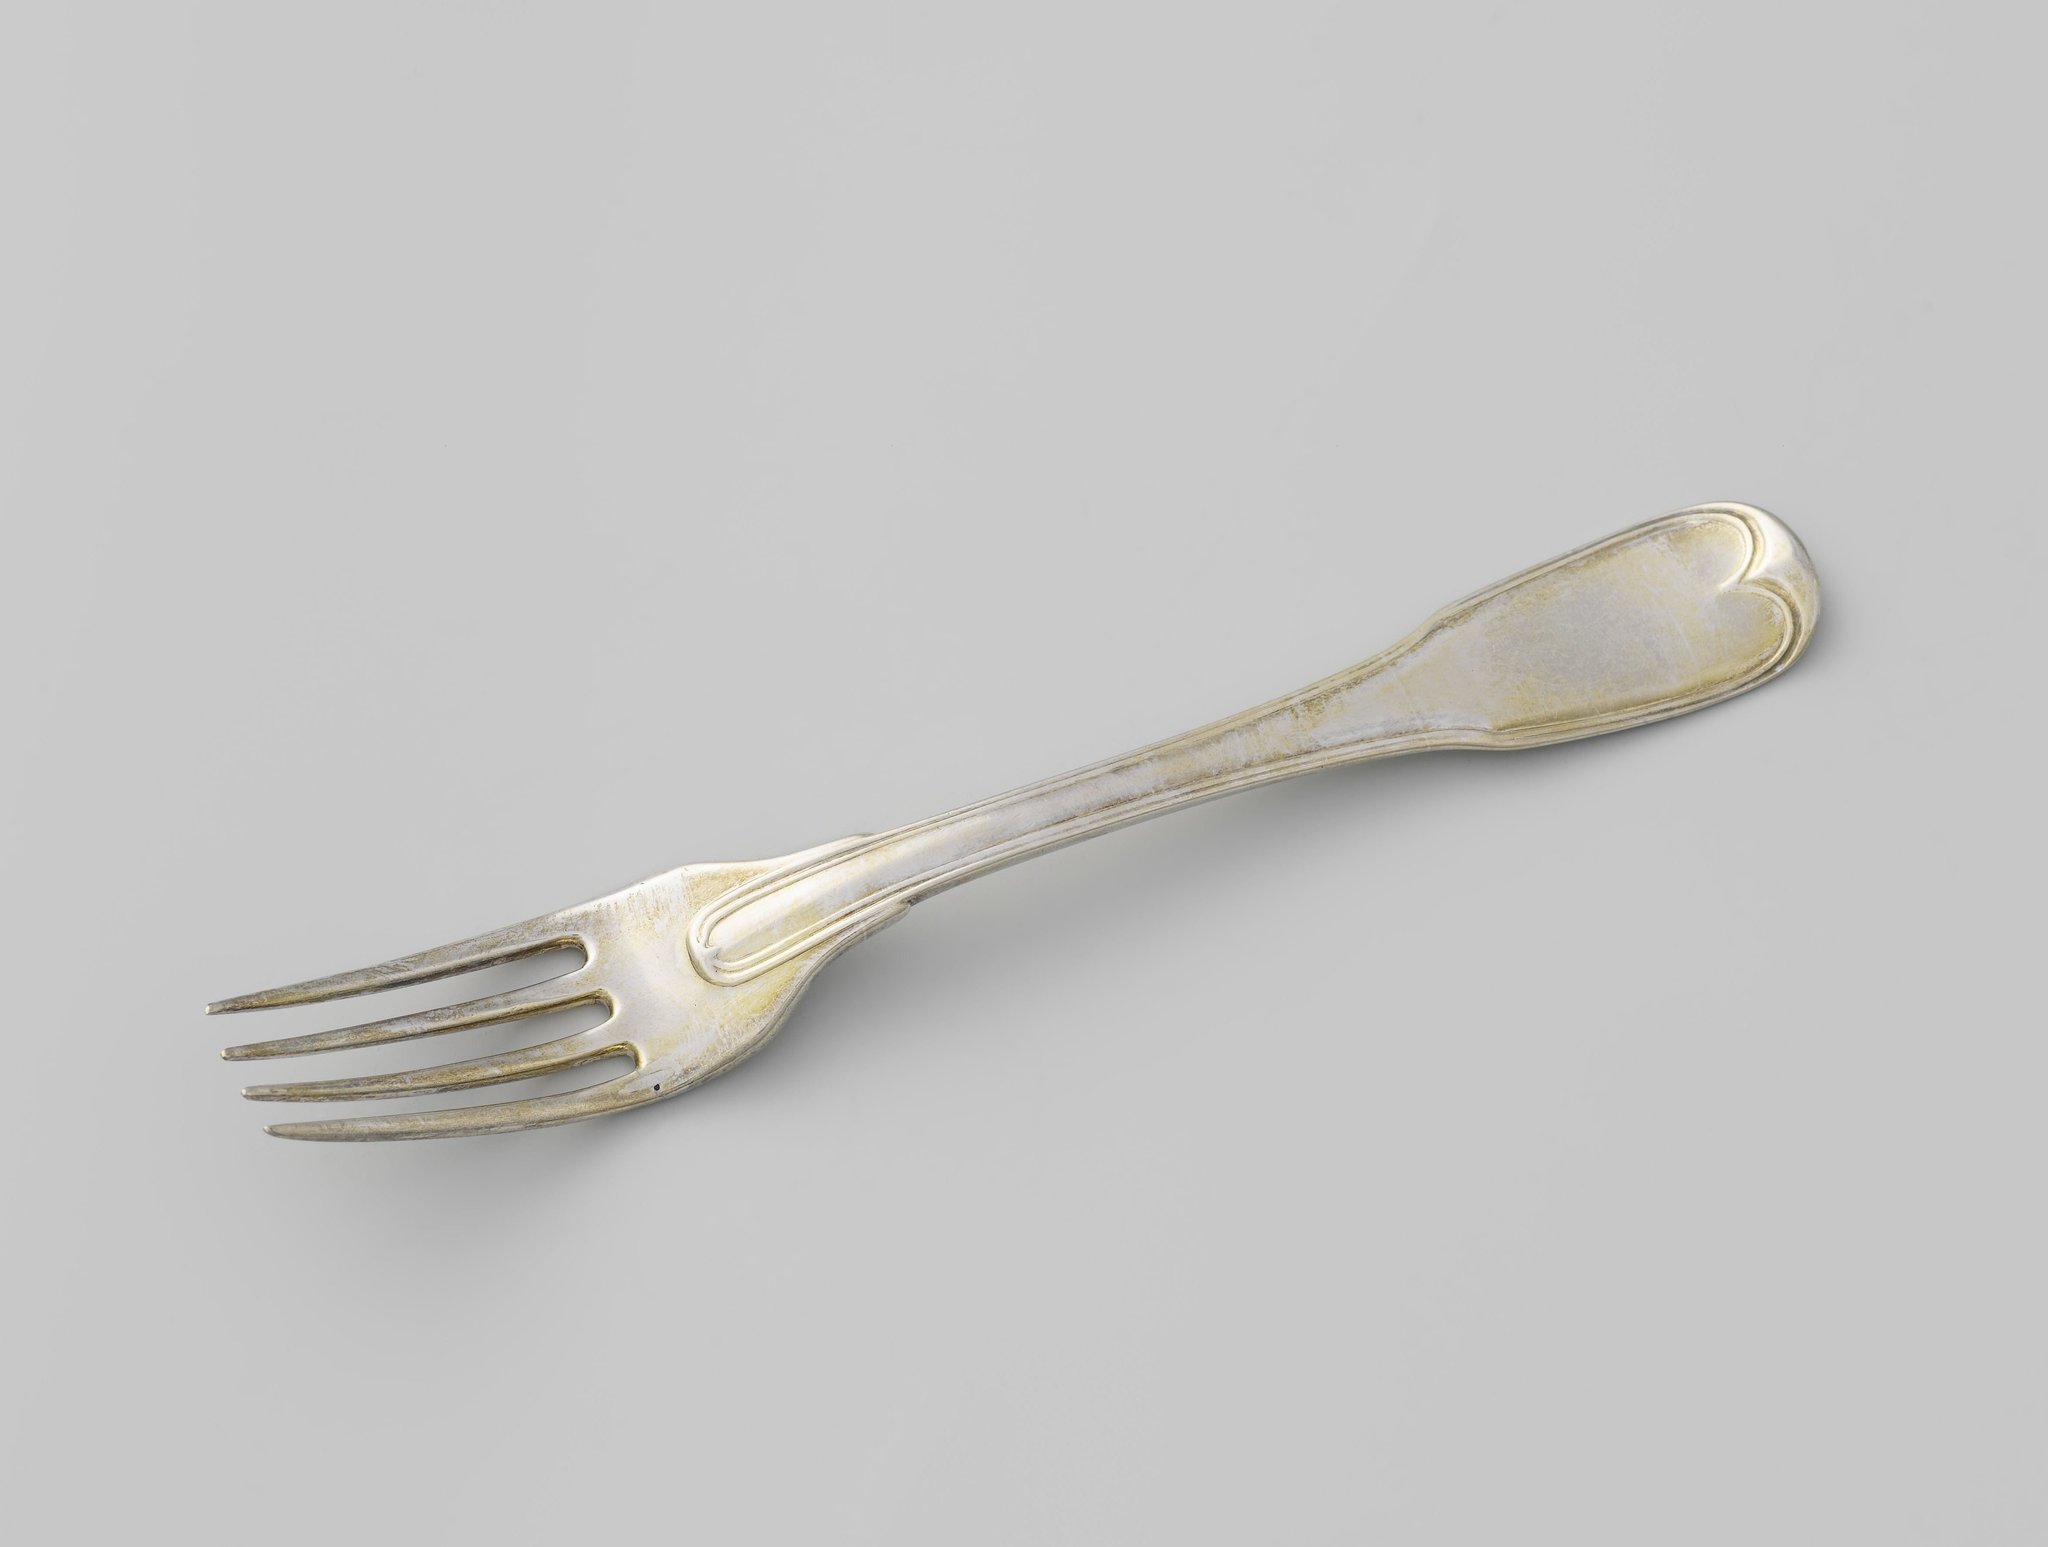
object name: fork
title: Vork met het helmteken Clifford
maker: roelof helweg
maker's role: silversmith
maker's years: 1758-1843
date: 1806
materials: silver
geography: amsterdam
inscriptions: alloy mark: ‘Hollandse leeuw’, date letter: ‘X (=1806)’, maker's mark: ‘RH in ovaal’, town mark: ‘Amsterdam’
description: De viertandige vork is aan zowel boven- als onderzijde door middel van enkel lof verbonden met de platte, gebogen steel, die zich verbreedt naar het spatelvormige uiteinde. Boven- en onderzijde van de steel worden omgeven door een dubbele filetrand, die bij het uiteinde ingezwenkt is. Op de onderzijde van de spatel is het helmteken Clifford gegraveerd.